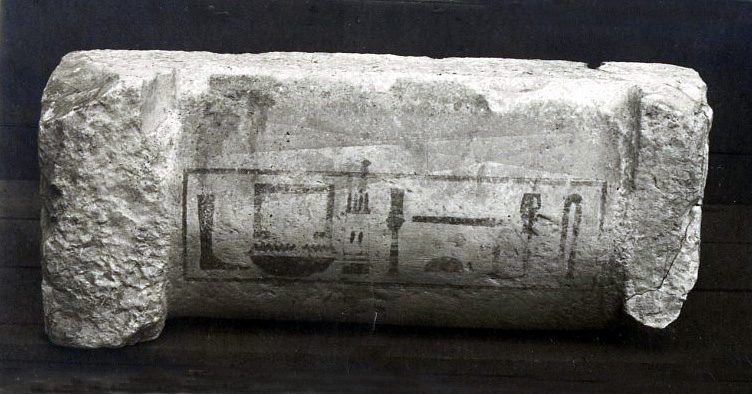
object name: door lintel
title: Inscribed lintel from Perneb's mastaba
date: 2381-2323 BCE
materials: limestone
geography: egypt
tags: hieroglyphs